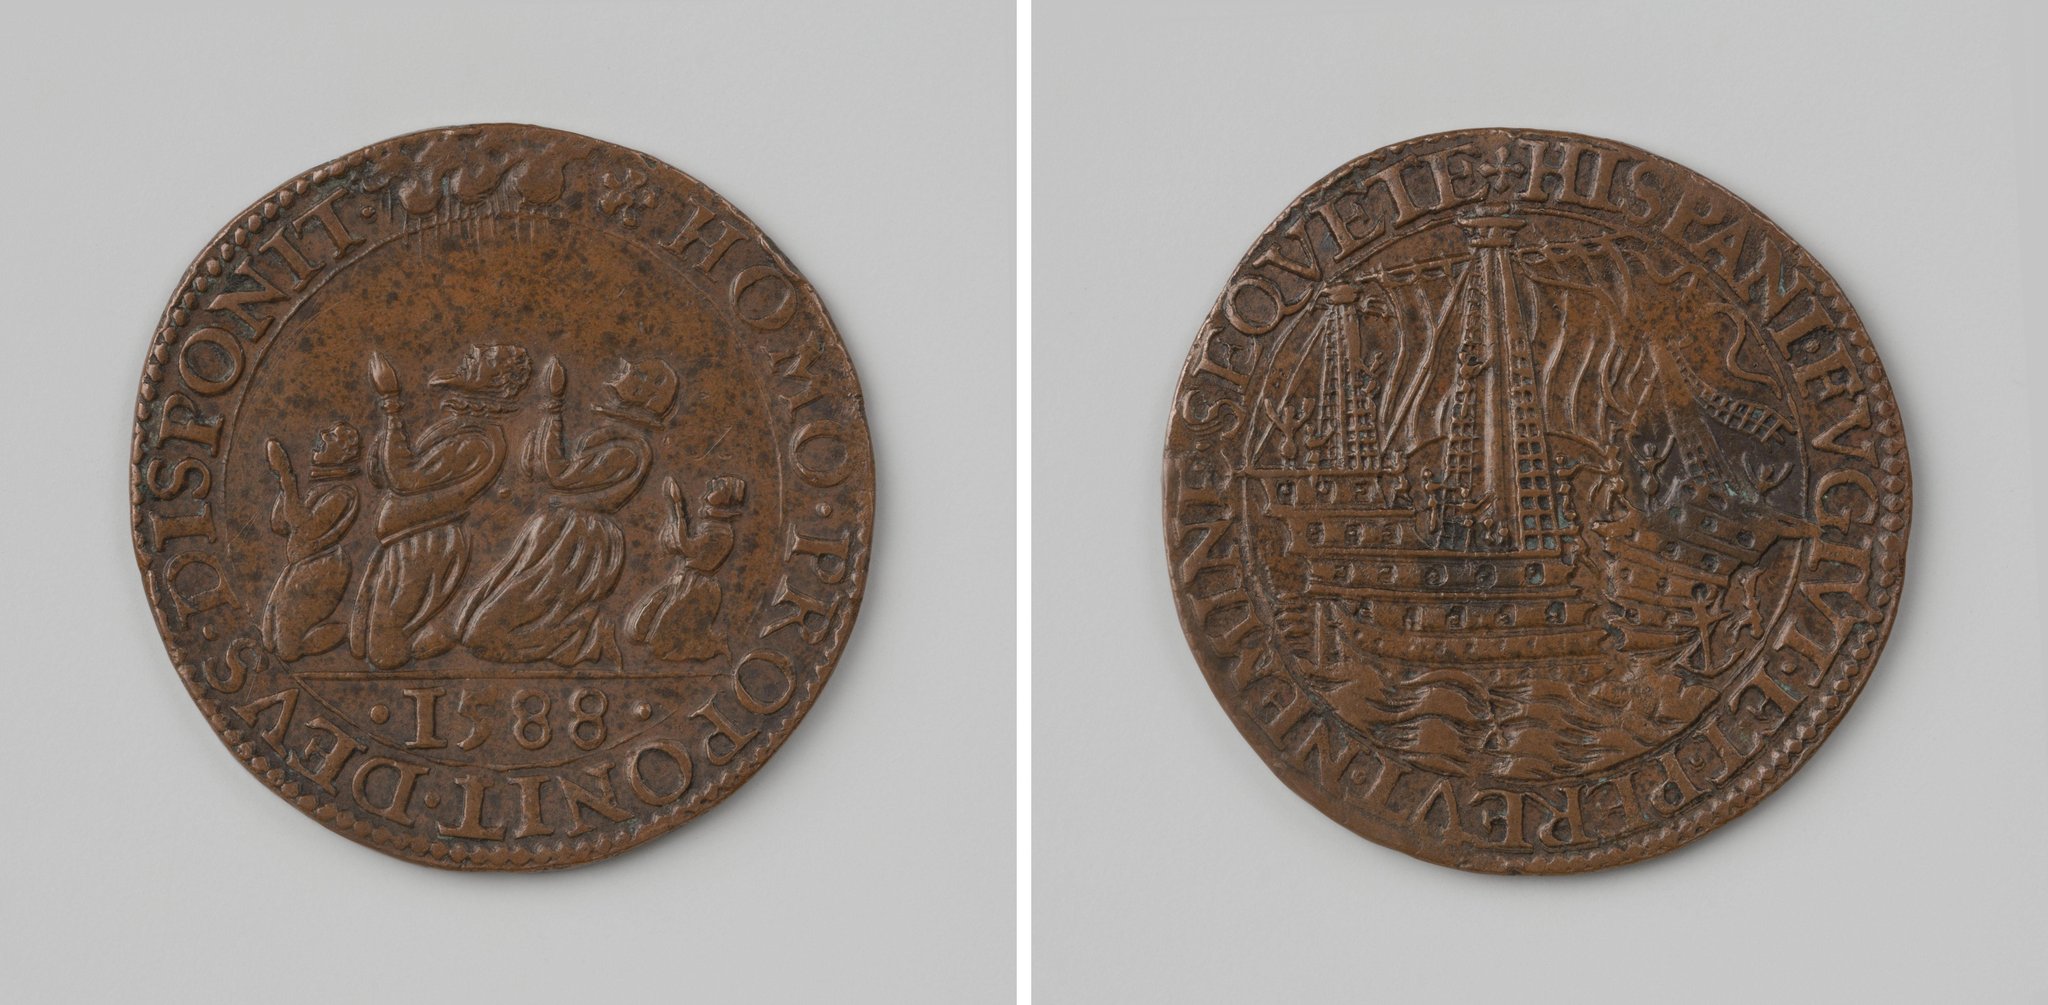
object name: jeton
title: Vergaan van de Spaanse armada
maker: Anonymous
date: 1588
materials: copper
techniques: striking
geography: dordrecht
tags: tachtigjarige oorlog, vergaan van de spaanse armada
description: Koperen penning. Voorzijde: man en vrouw, geflankeerd door twee kinderen zitten op hun knieen met handen gevouwen en blik omhoog gewend binnen omschrift; afsnede: jaartal. Keerzijde: in tweeen gebroken schip binnen omschrift